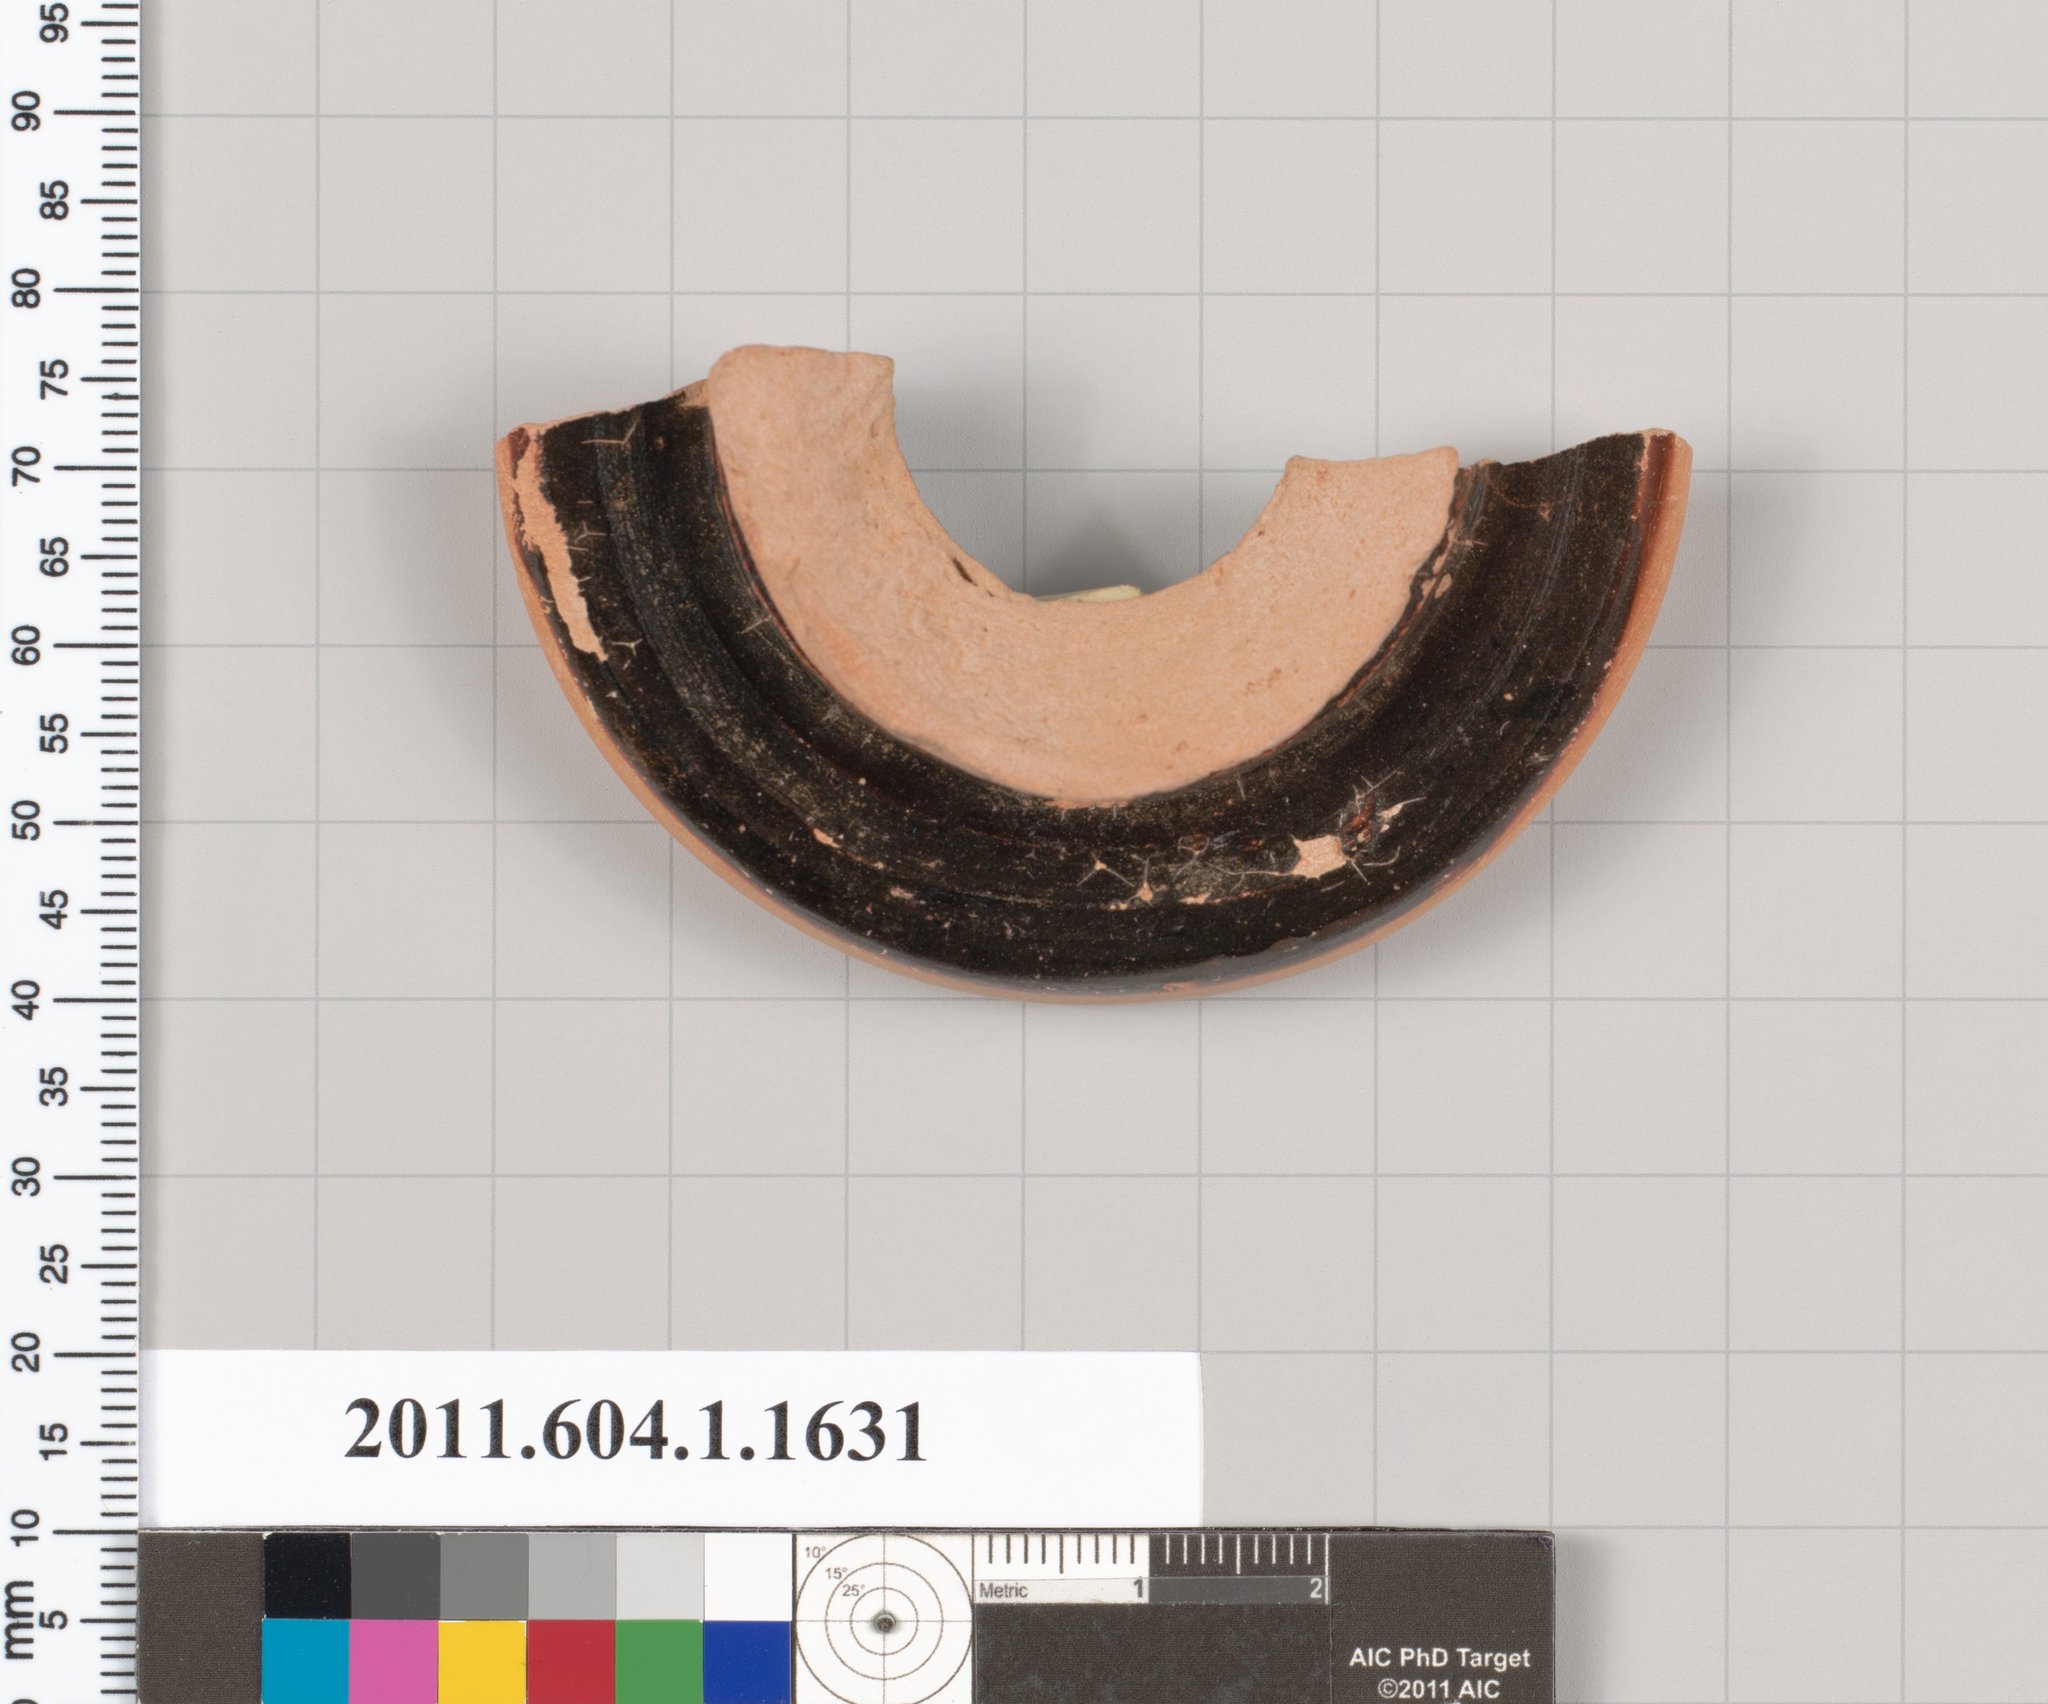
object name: kylix fragment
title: Terracotta fragment of a kylix (drinking cup)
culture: greek, attic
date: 500-401 BCE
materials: terracotta